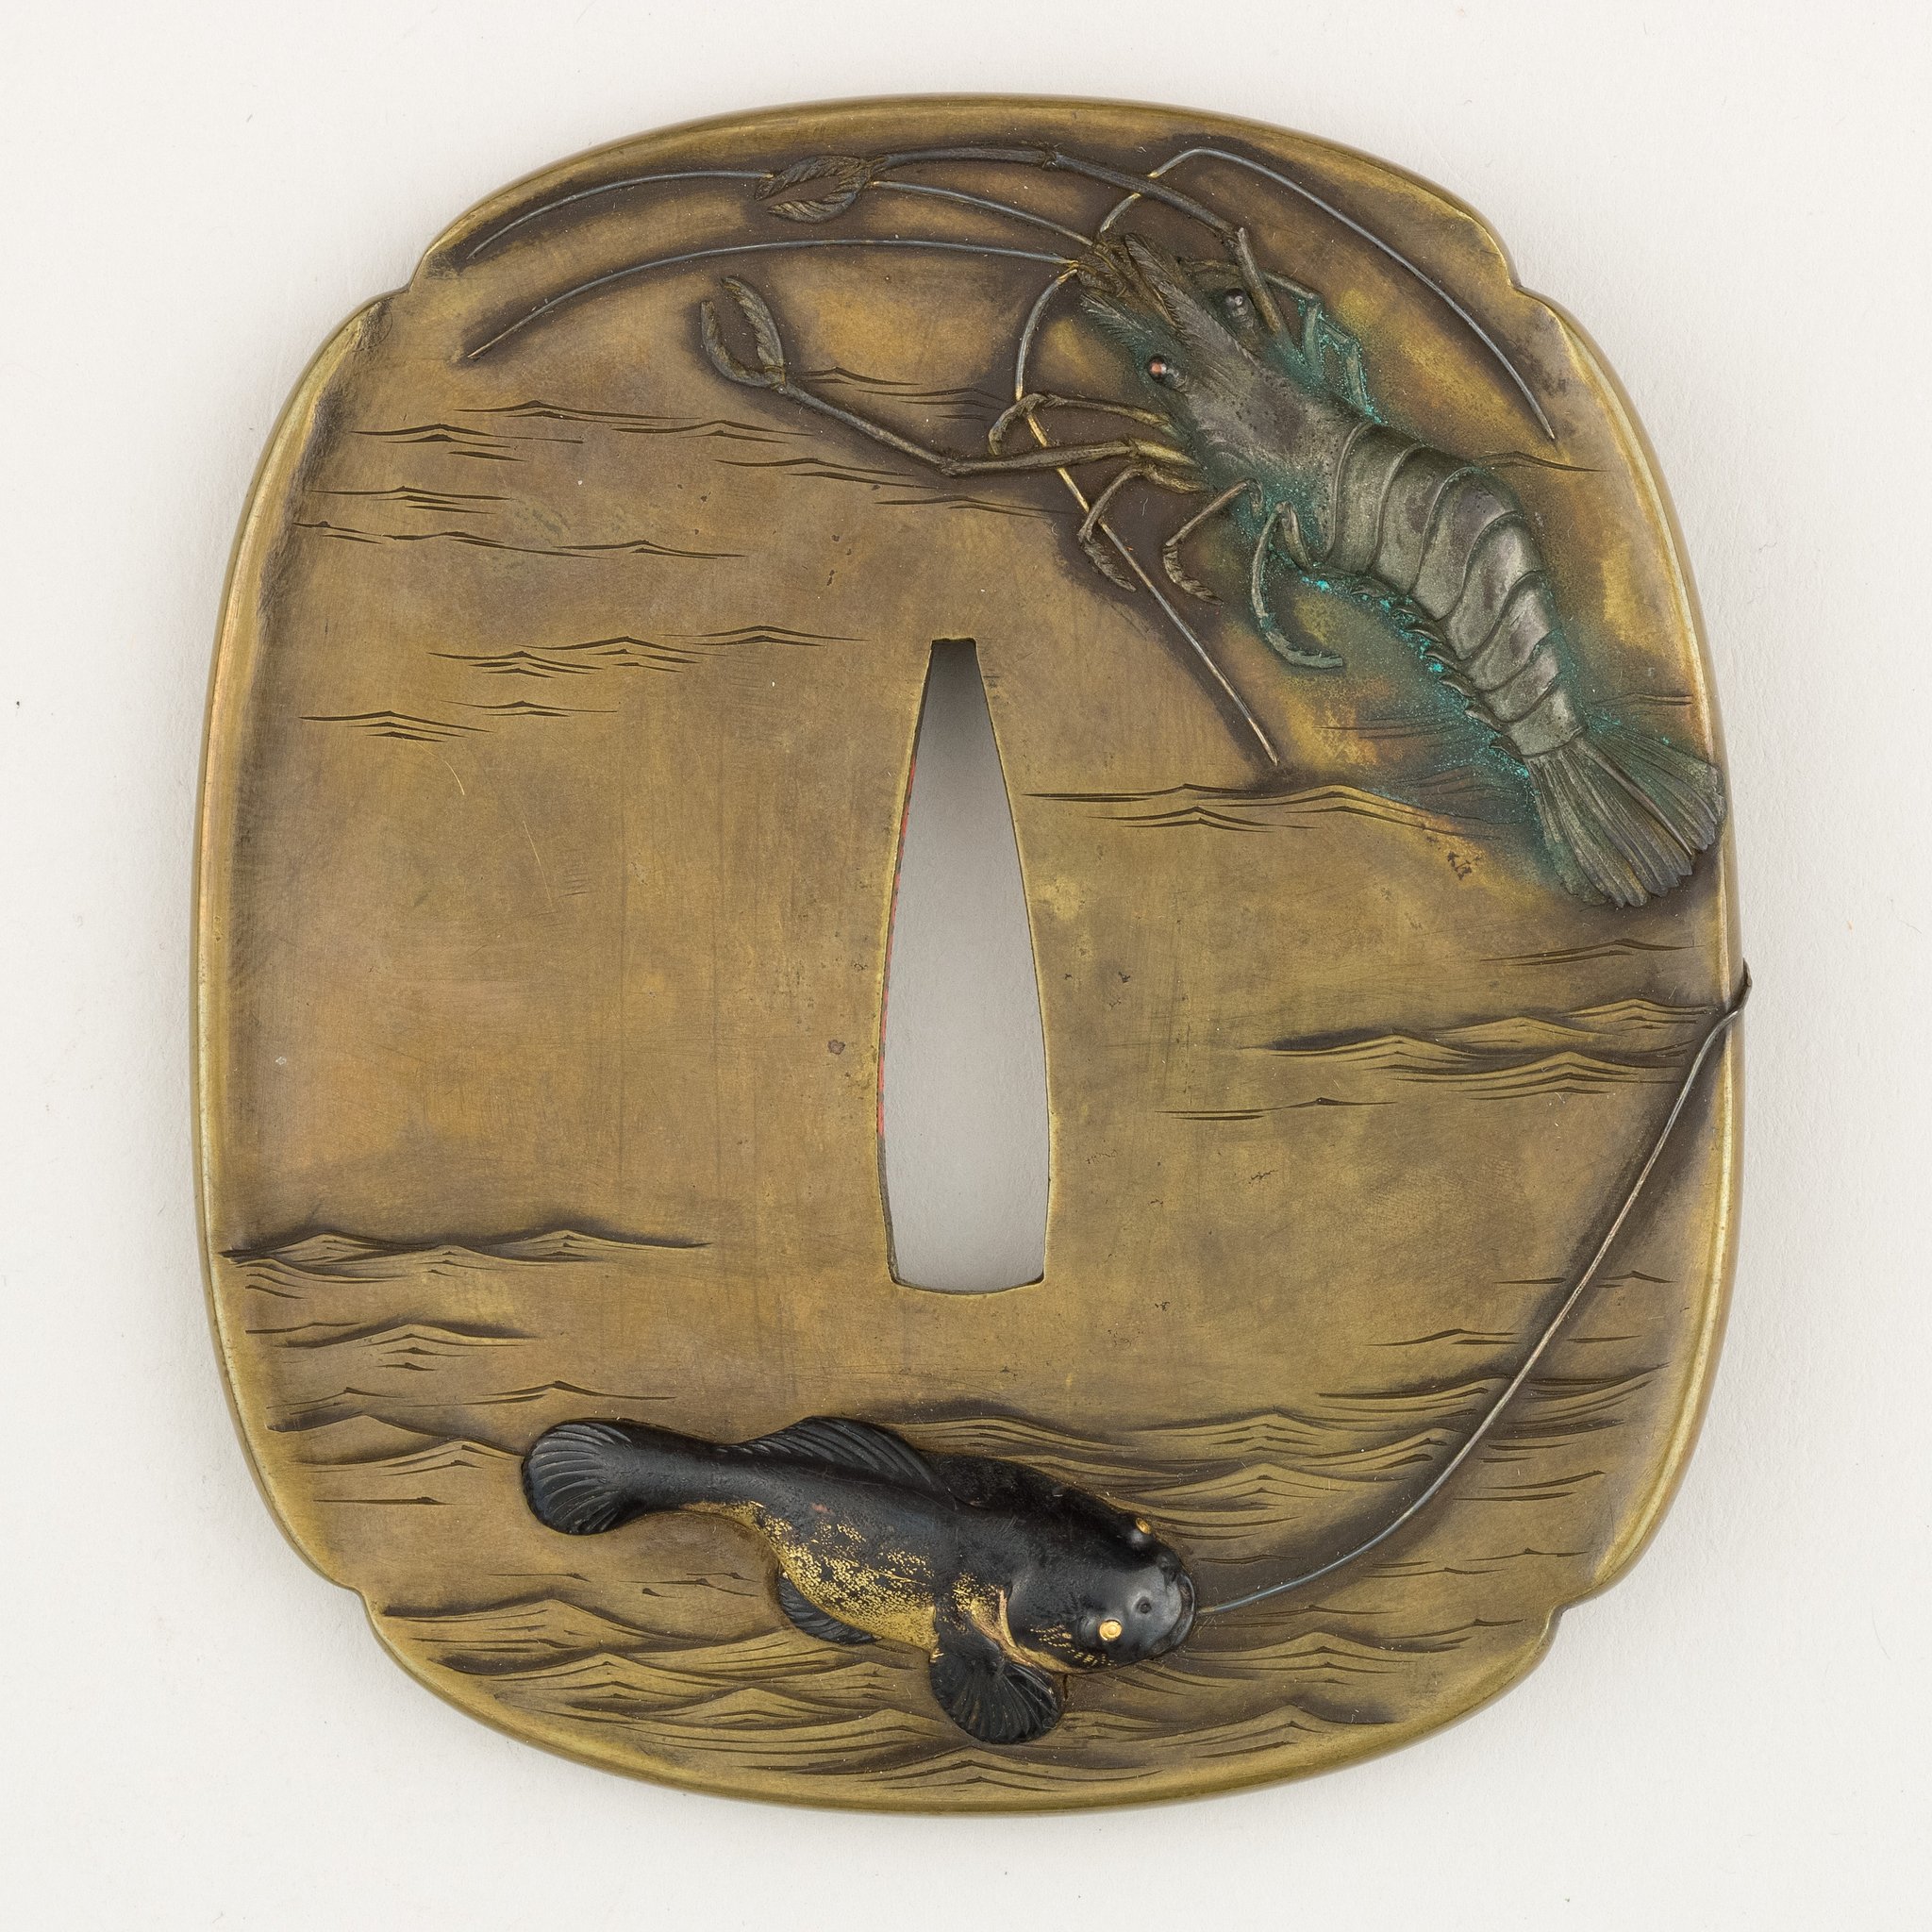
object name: sword guard tsuba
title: Sword Guard (Tsuba)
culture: japanese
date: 1615-1868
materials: copper, gold alloy, silver alloy, gold, silver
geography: japan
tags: fish,lobsters